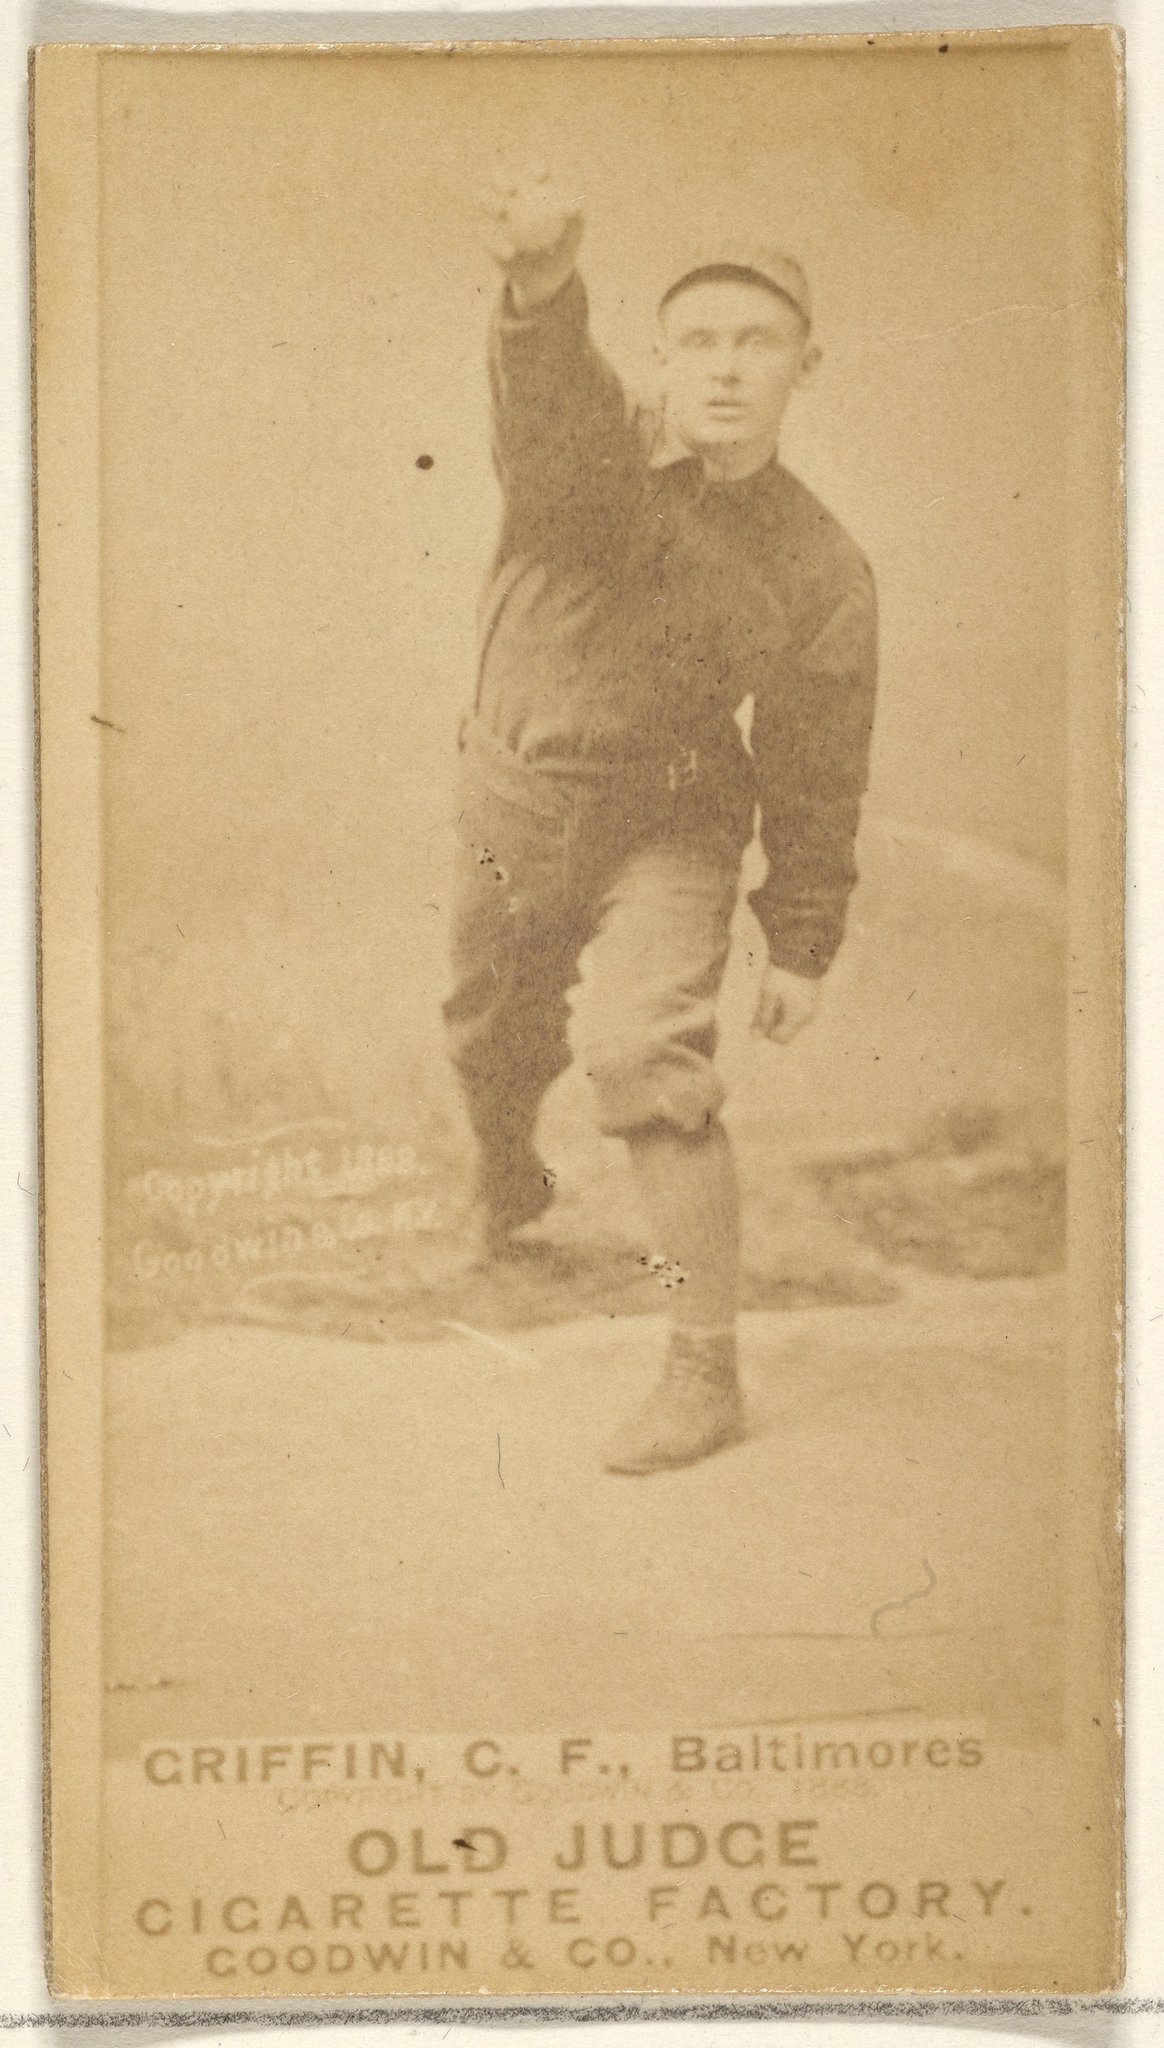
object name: baseball card, photograph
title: Griffin, Center Field, Baltimore Orioles, from the Old Judge series (N172) for Old Judge Cigarettes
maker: goodwin & company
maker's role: publisher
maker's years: 1850-1950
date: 1887-1890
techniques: albumen silver print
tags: men,portraits,baseball,athletes